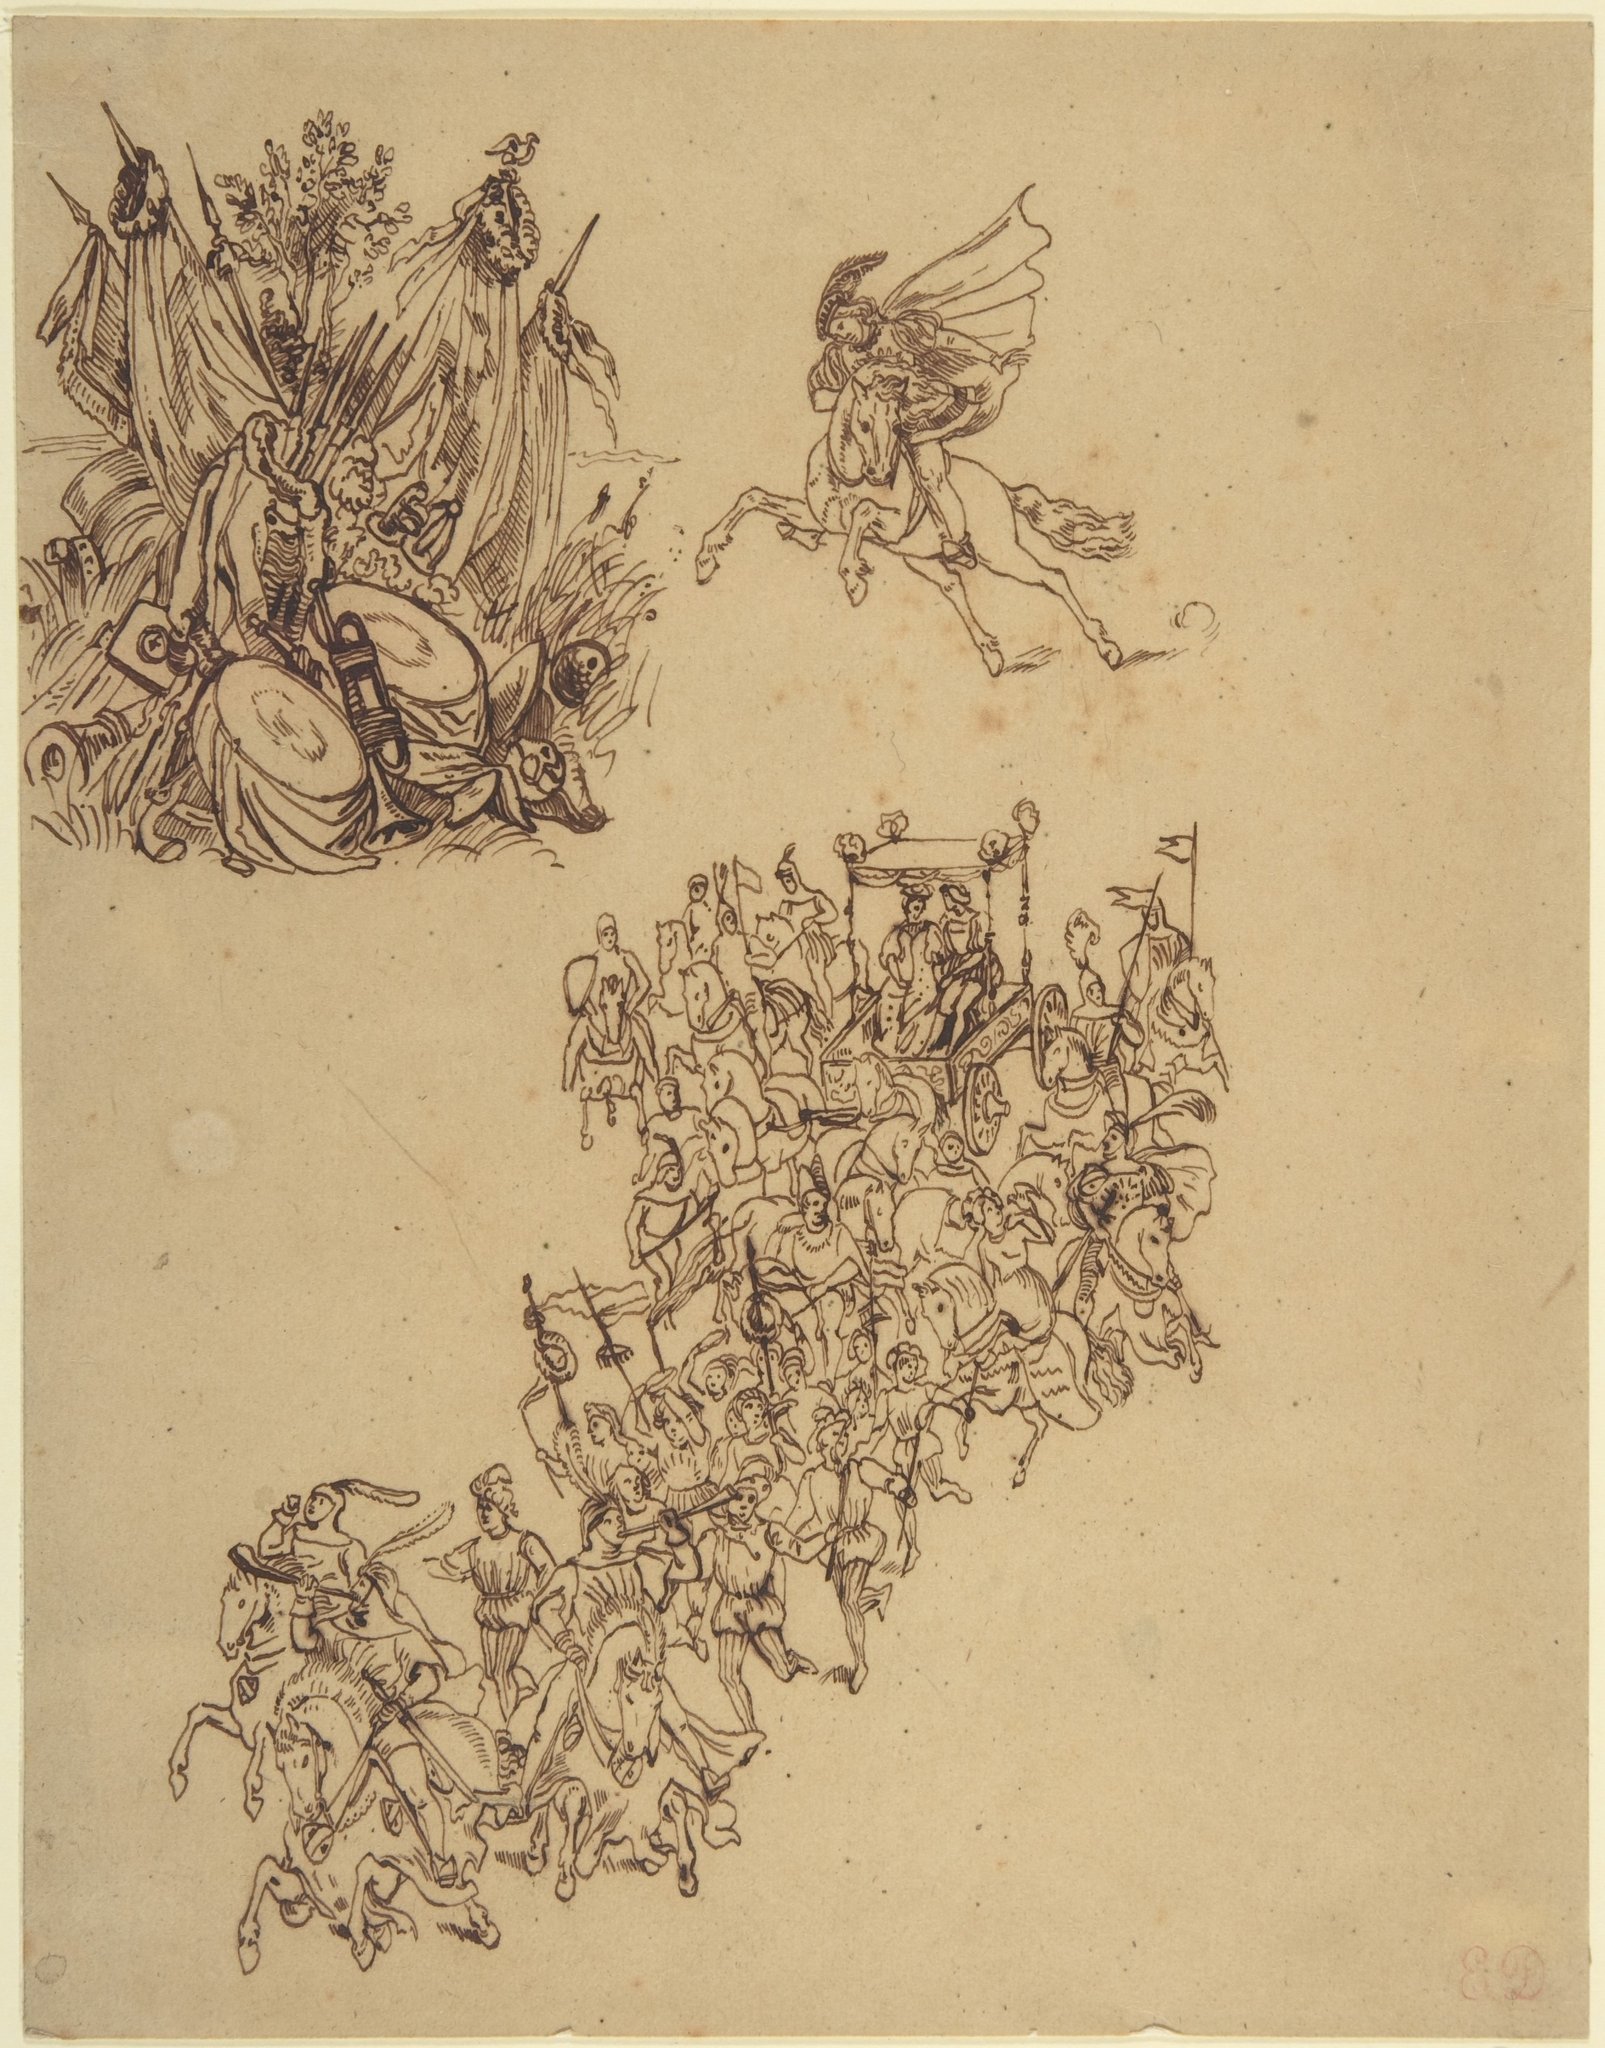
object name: drawing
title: Sheet of Studies: A Marriage Procession in Sixteenth-Century Dress; a Cavalier; and a Trophy of Arms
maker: eugène delacroix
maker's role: artist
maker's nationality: french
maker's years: 1798-1863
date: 1798-1863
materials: ink, paper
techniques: pen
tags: horses,carriages